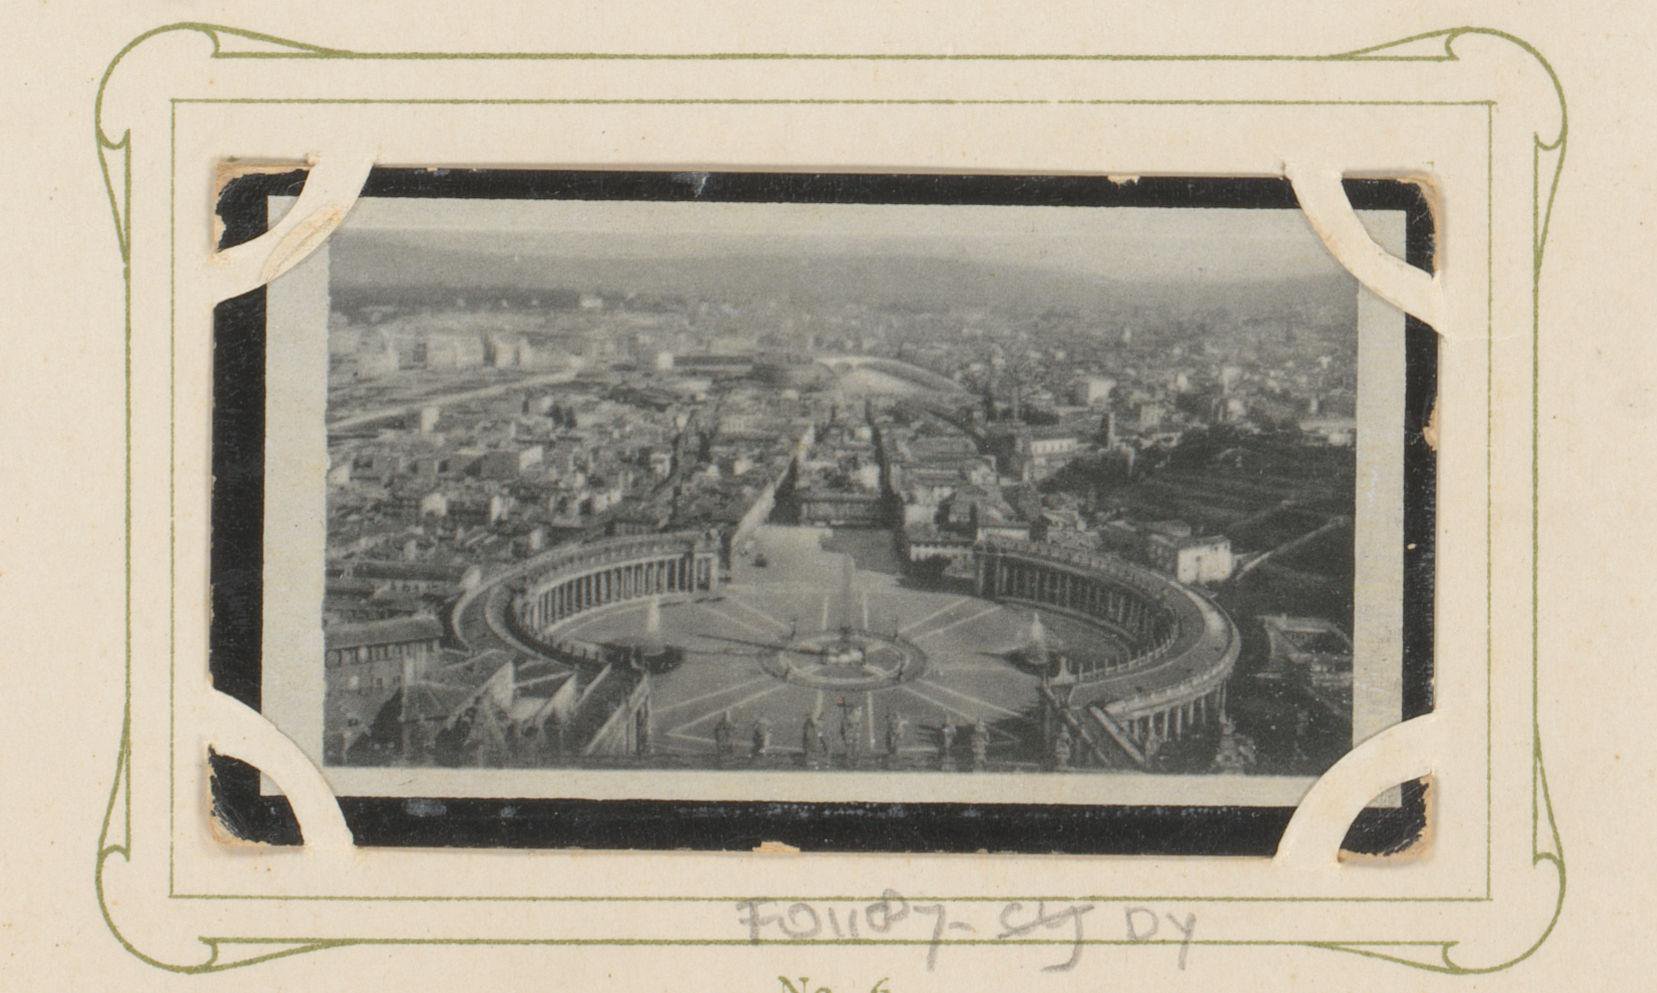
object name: photomechanical print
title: Gezicht op het Sint-Pietersplein in Rome, Italië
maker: Anonymous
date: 1905-1906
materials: paper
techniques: photograph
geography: rome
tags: square, place, circus, etc., prospect of city, town panorama, silhouette of city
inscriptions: inscription: ‘No. 6./ Panorama Rome.’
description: Deze prent maakt deel uit van een album.